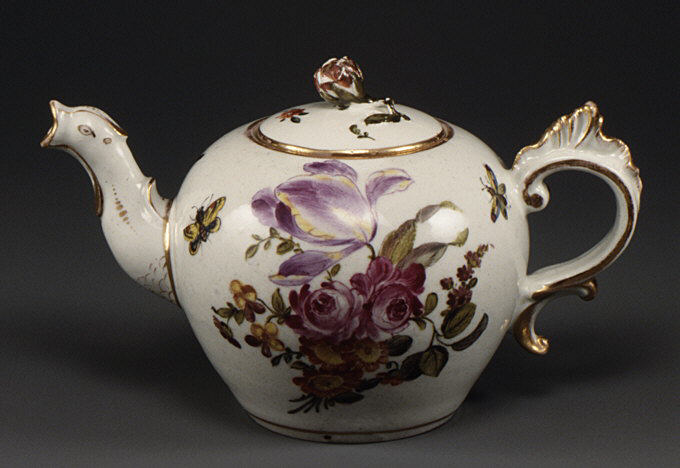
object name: teapot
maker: meissen manufactory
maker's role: manufactory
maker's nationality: german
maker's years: 1710-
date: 1740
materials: hard paste porcelain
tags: birds,butterflies,roses